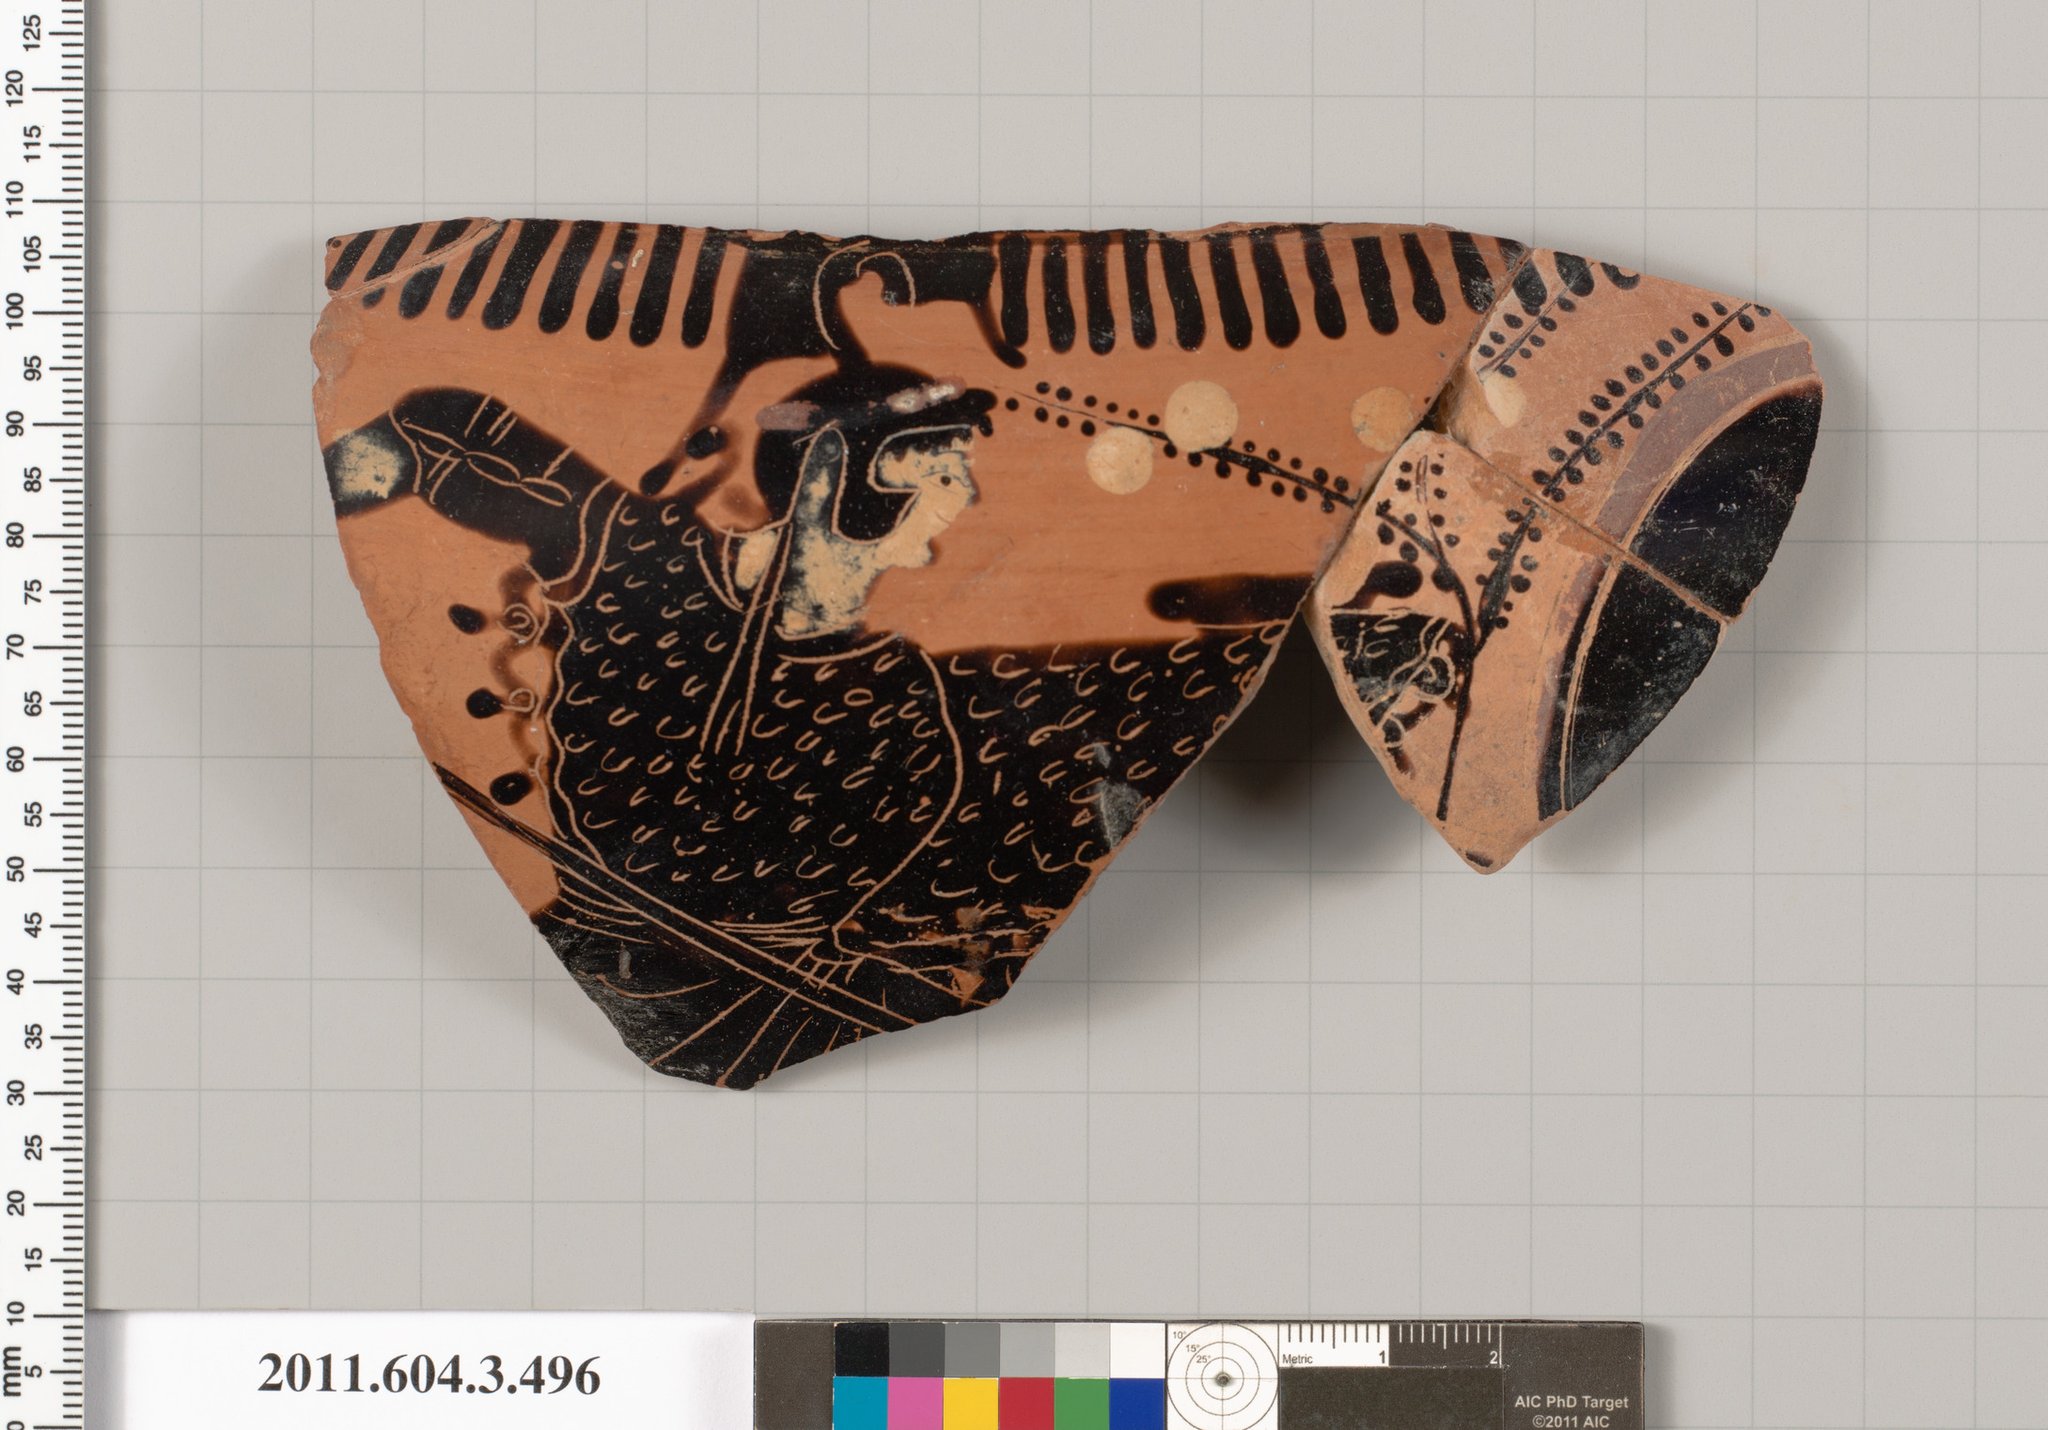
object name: column krater fragment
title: Terracotta fragment of a column-krater (bowl for mixing wine and water)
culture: greek, attic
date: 550-526 BCE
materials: terracotta